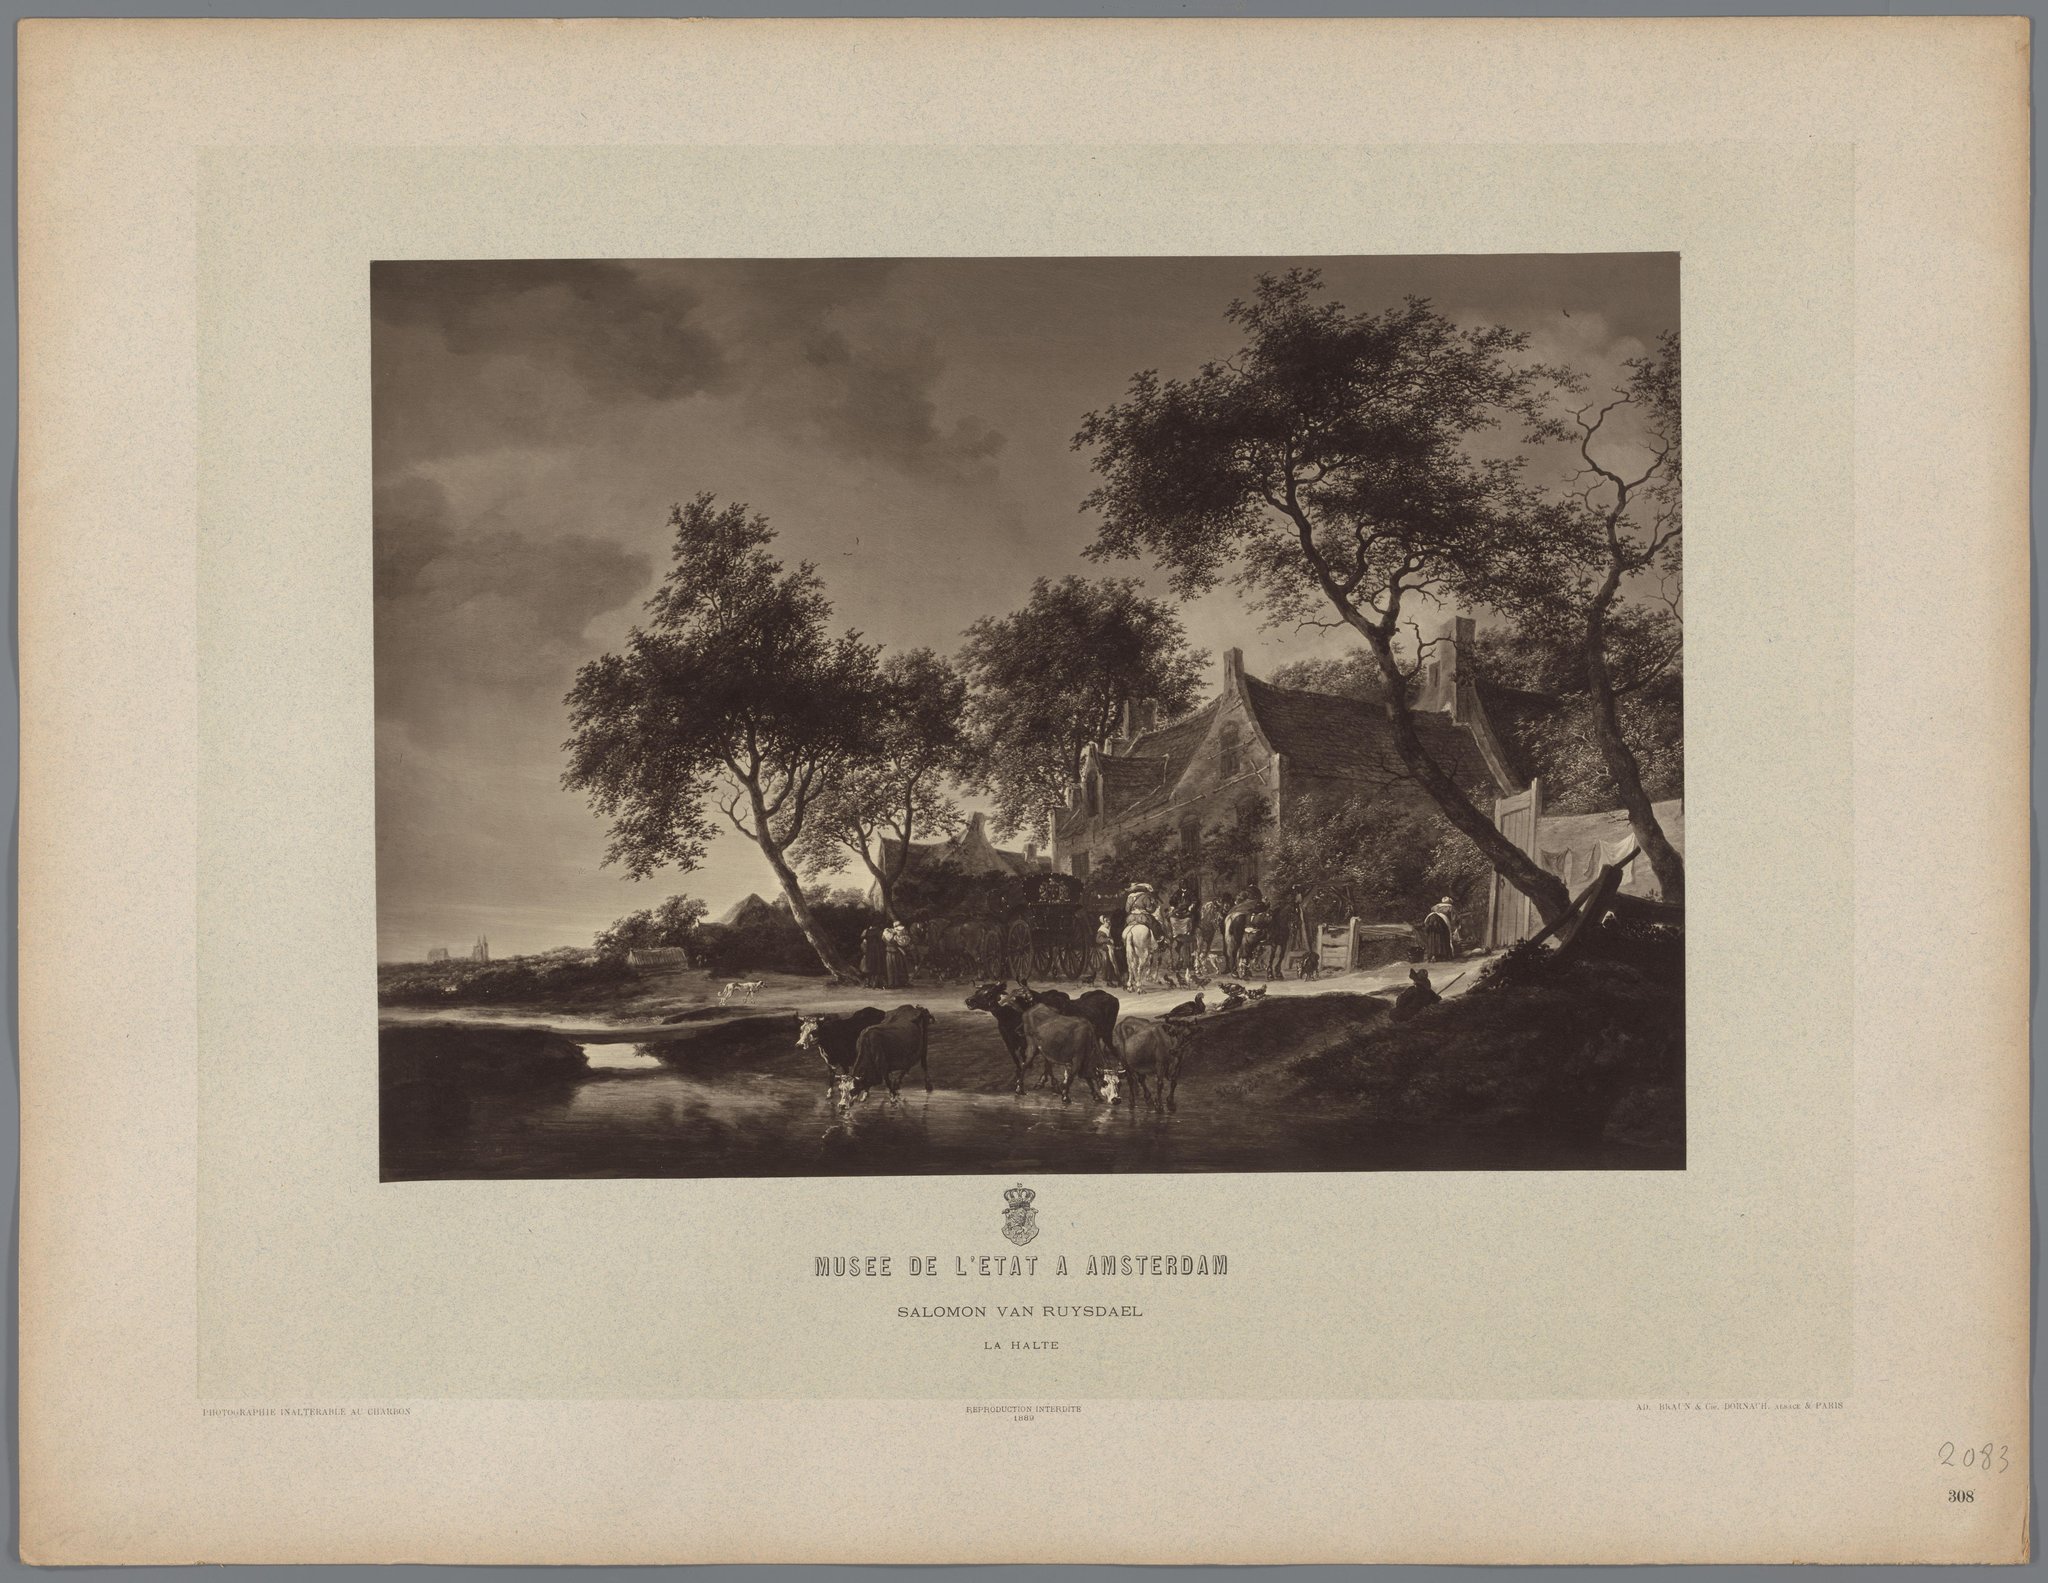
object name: photograph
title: Fotoreproductie van een schilderij van Salomon van Ruysdael, 'Dorpsherberg met reiswagen' (coll. Rijksmuseum)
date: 1889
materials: cardboard, paper, photographic support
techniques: carbon print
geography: netherlands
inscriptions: annotation: ‘F. 10 / A / 30/3 08’